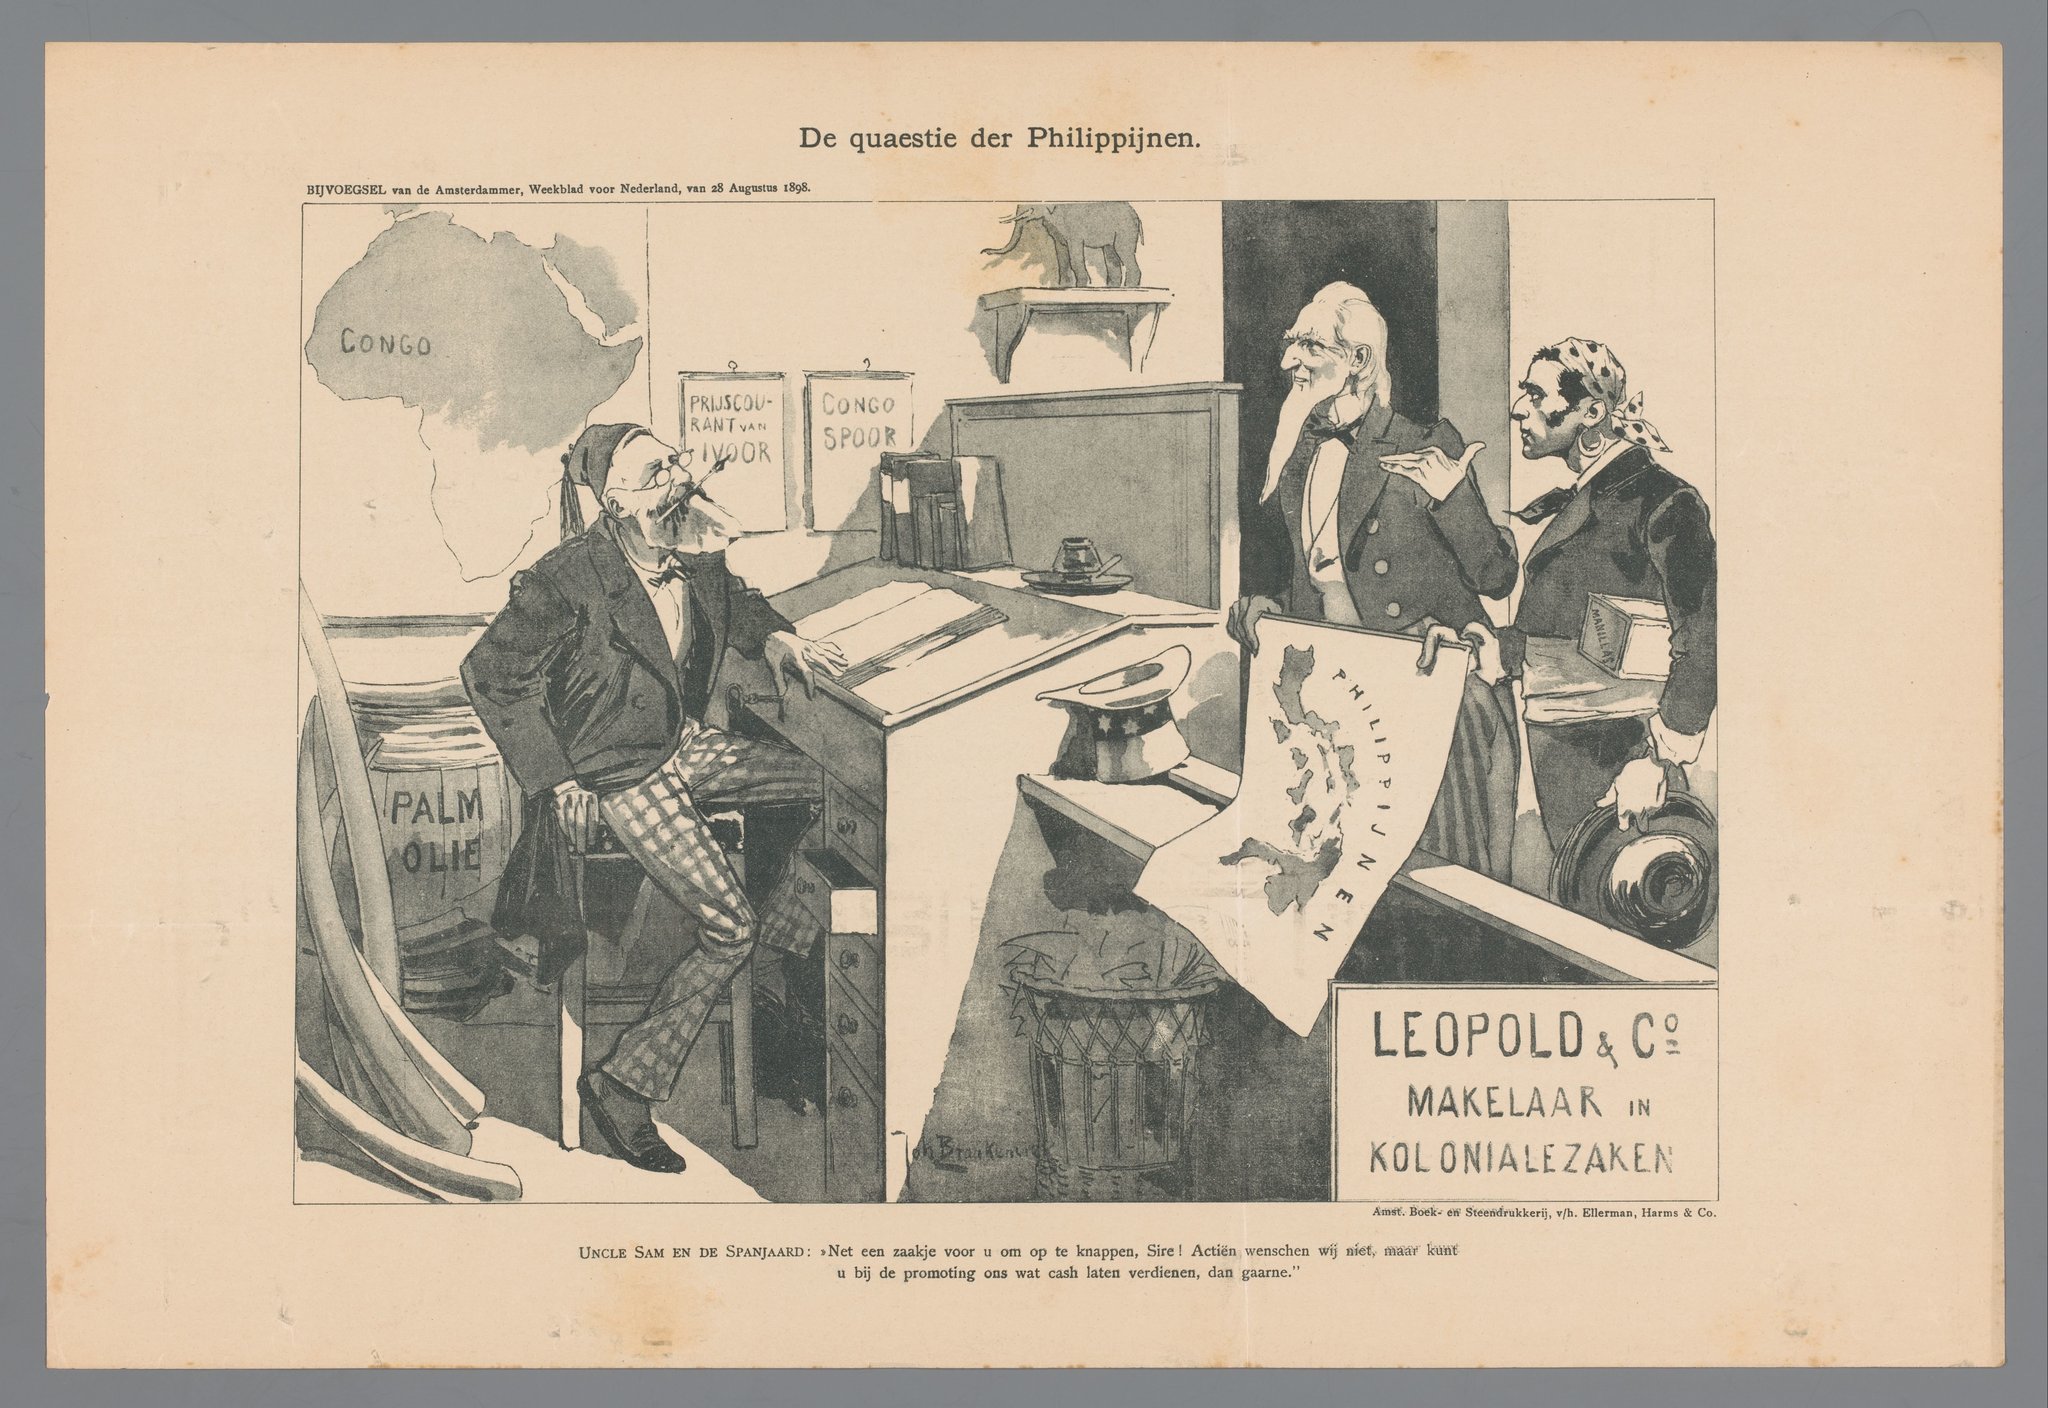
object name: cartoon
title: De quaestie der Philippijnen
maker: johan braakensiek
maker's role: draughtsman, print maker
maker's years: 1858-1940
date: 1898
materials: paper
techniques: lithograph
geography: amsterdam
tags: brussels, laeken, leopold ii (koning der belgen), colonial system, maps of separate countries or regions, (map of) africa, personifications of countries, nations, states, districts, etc. (+ nation; national), political caricatures and satires, philippines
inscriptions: date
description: Prent uit het bijvoegsel van: De Amsterdammer. Weekblad voor Nederland, 28 augustus 1898.